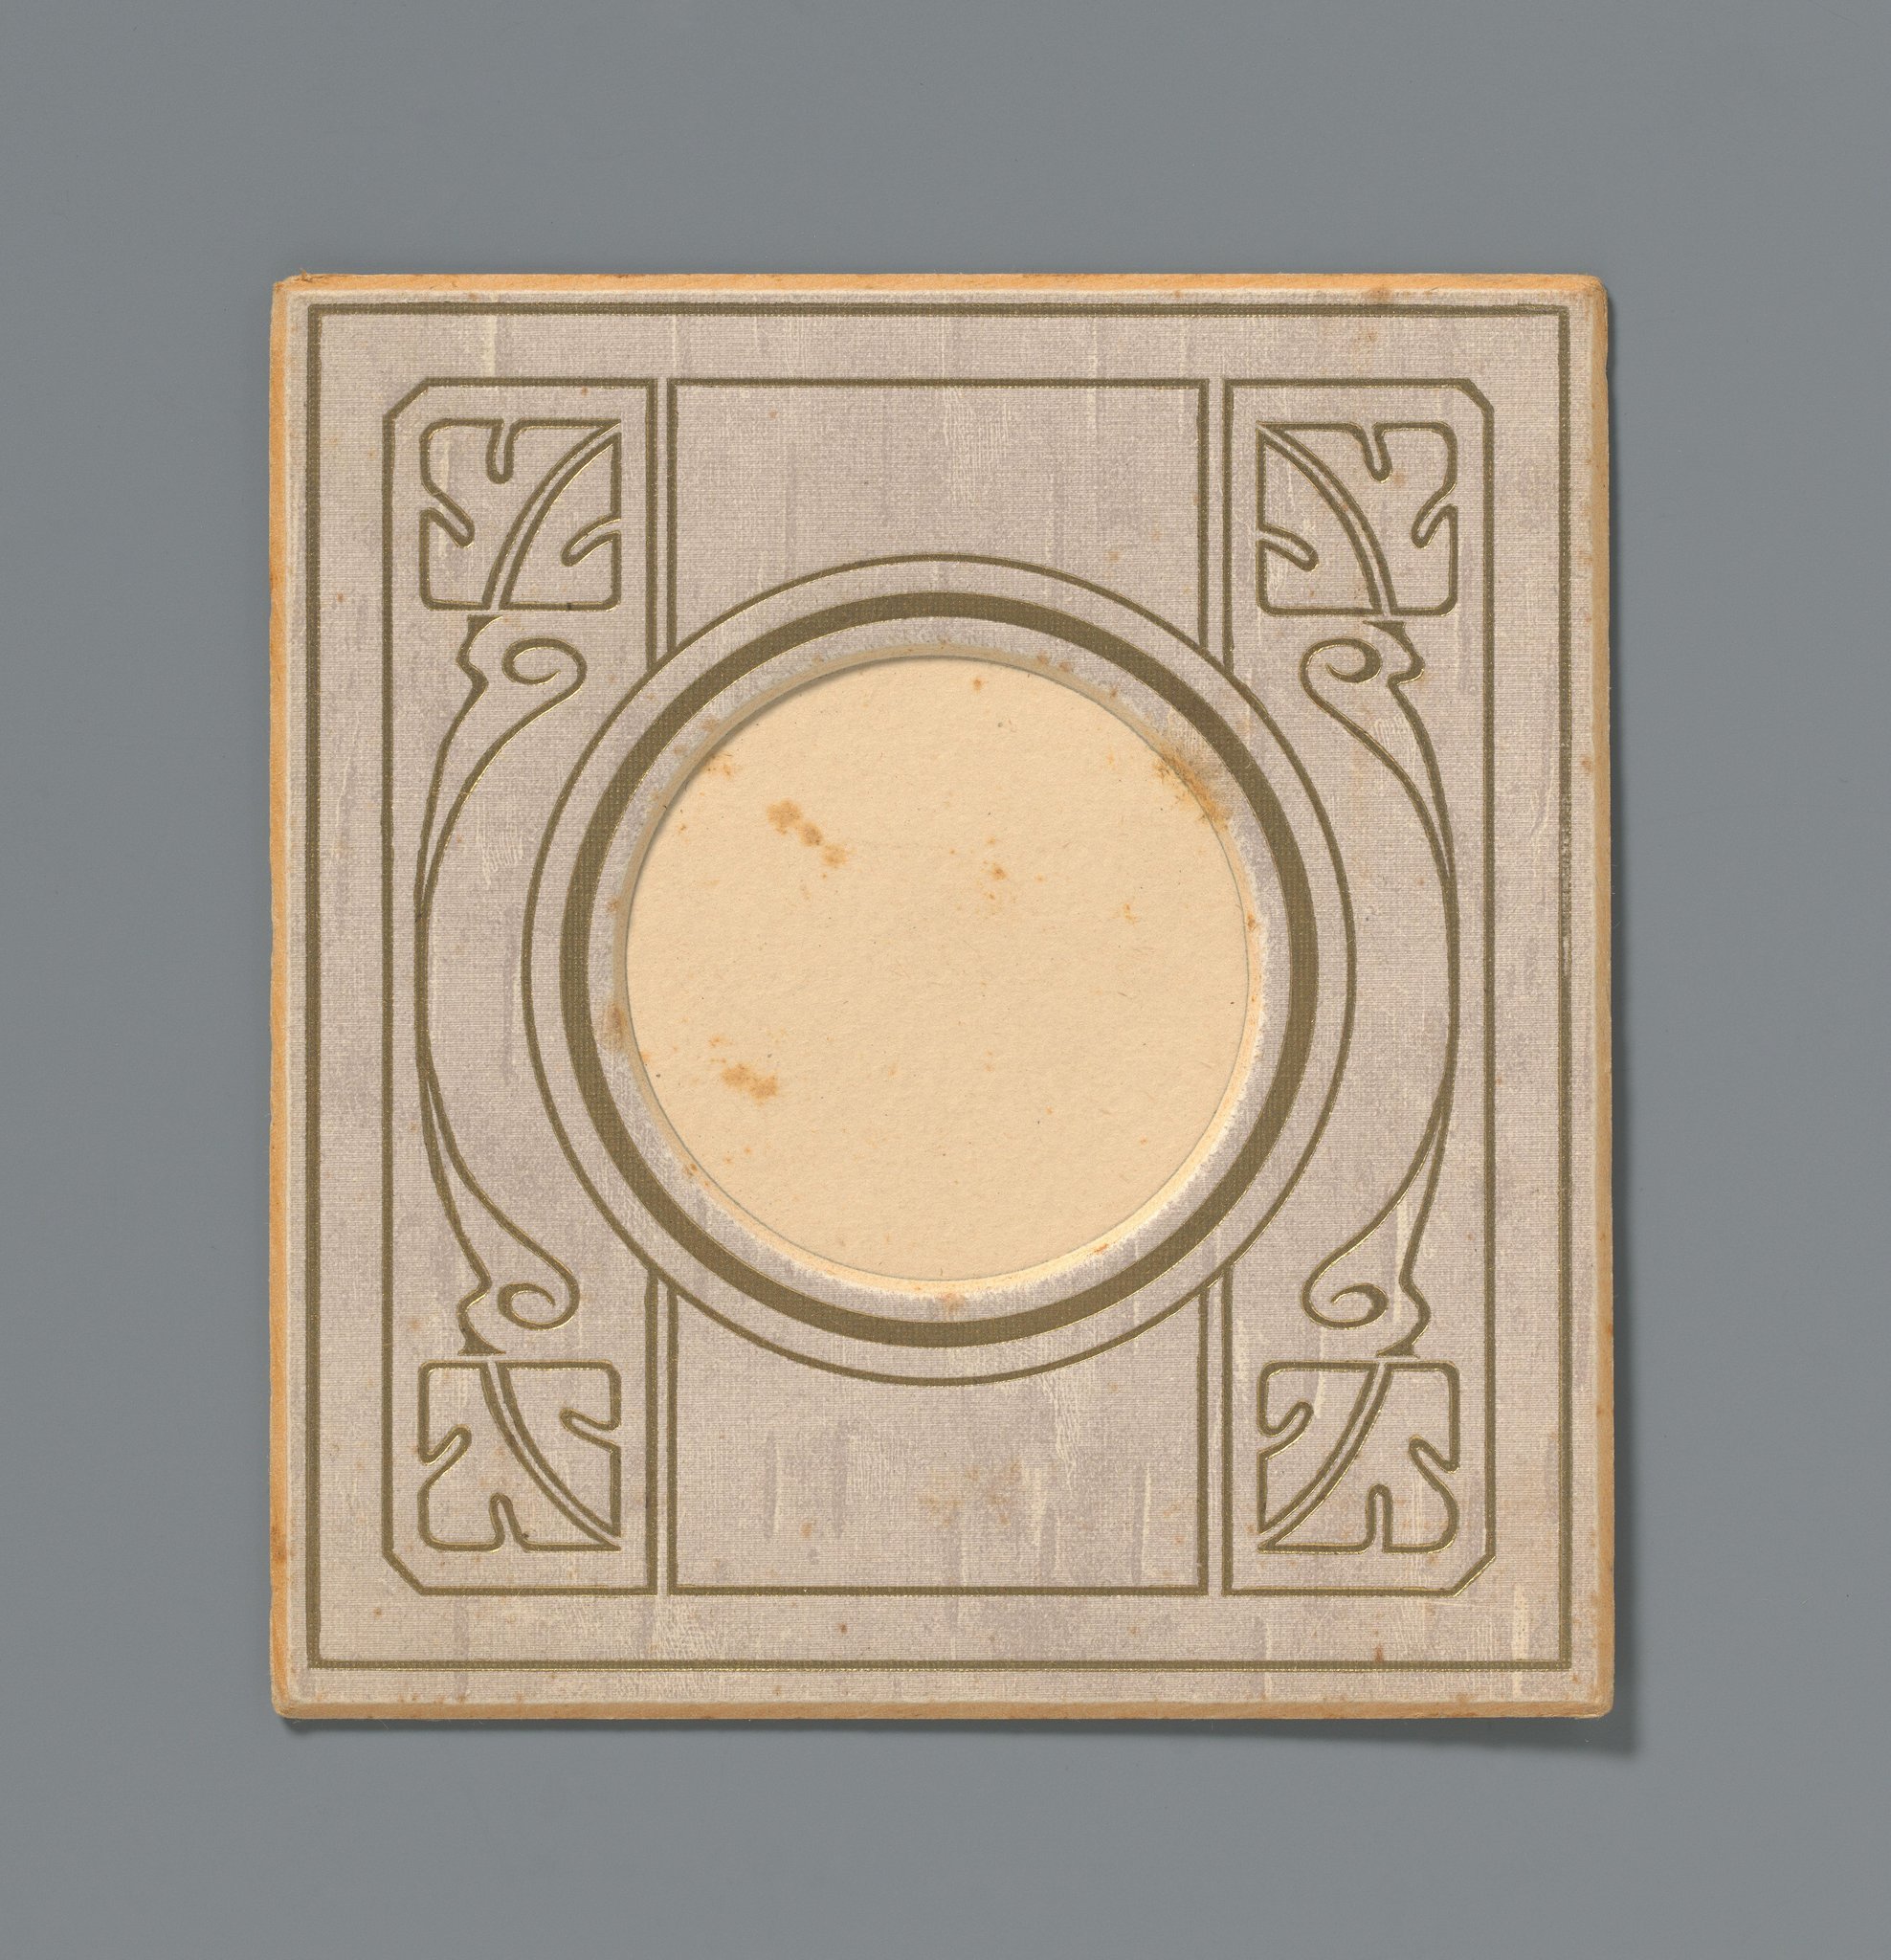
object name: passe partout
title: Leeg passe-partout met jugendstilmotief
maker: Anonymous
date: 1890-1910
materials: cardboard, paper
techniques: gold embossing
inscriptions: inscription: ‘3345/ e/ 7 1/2’